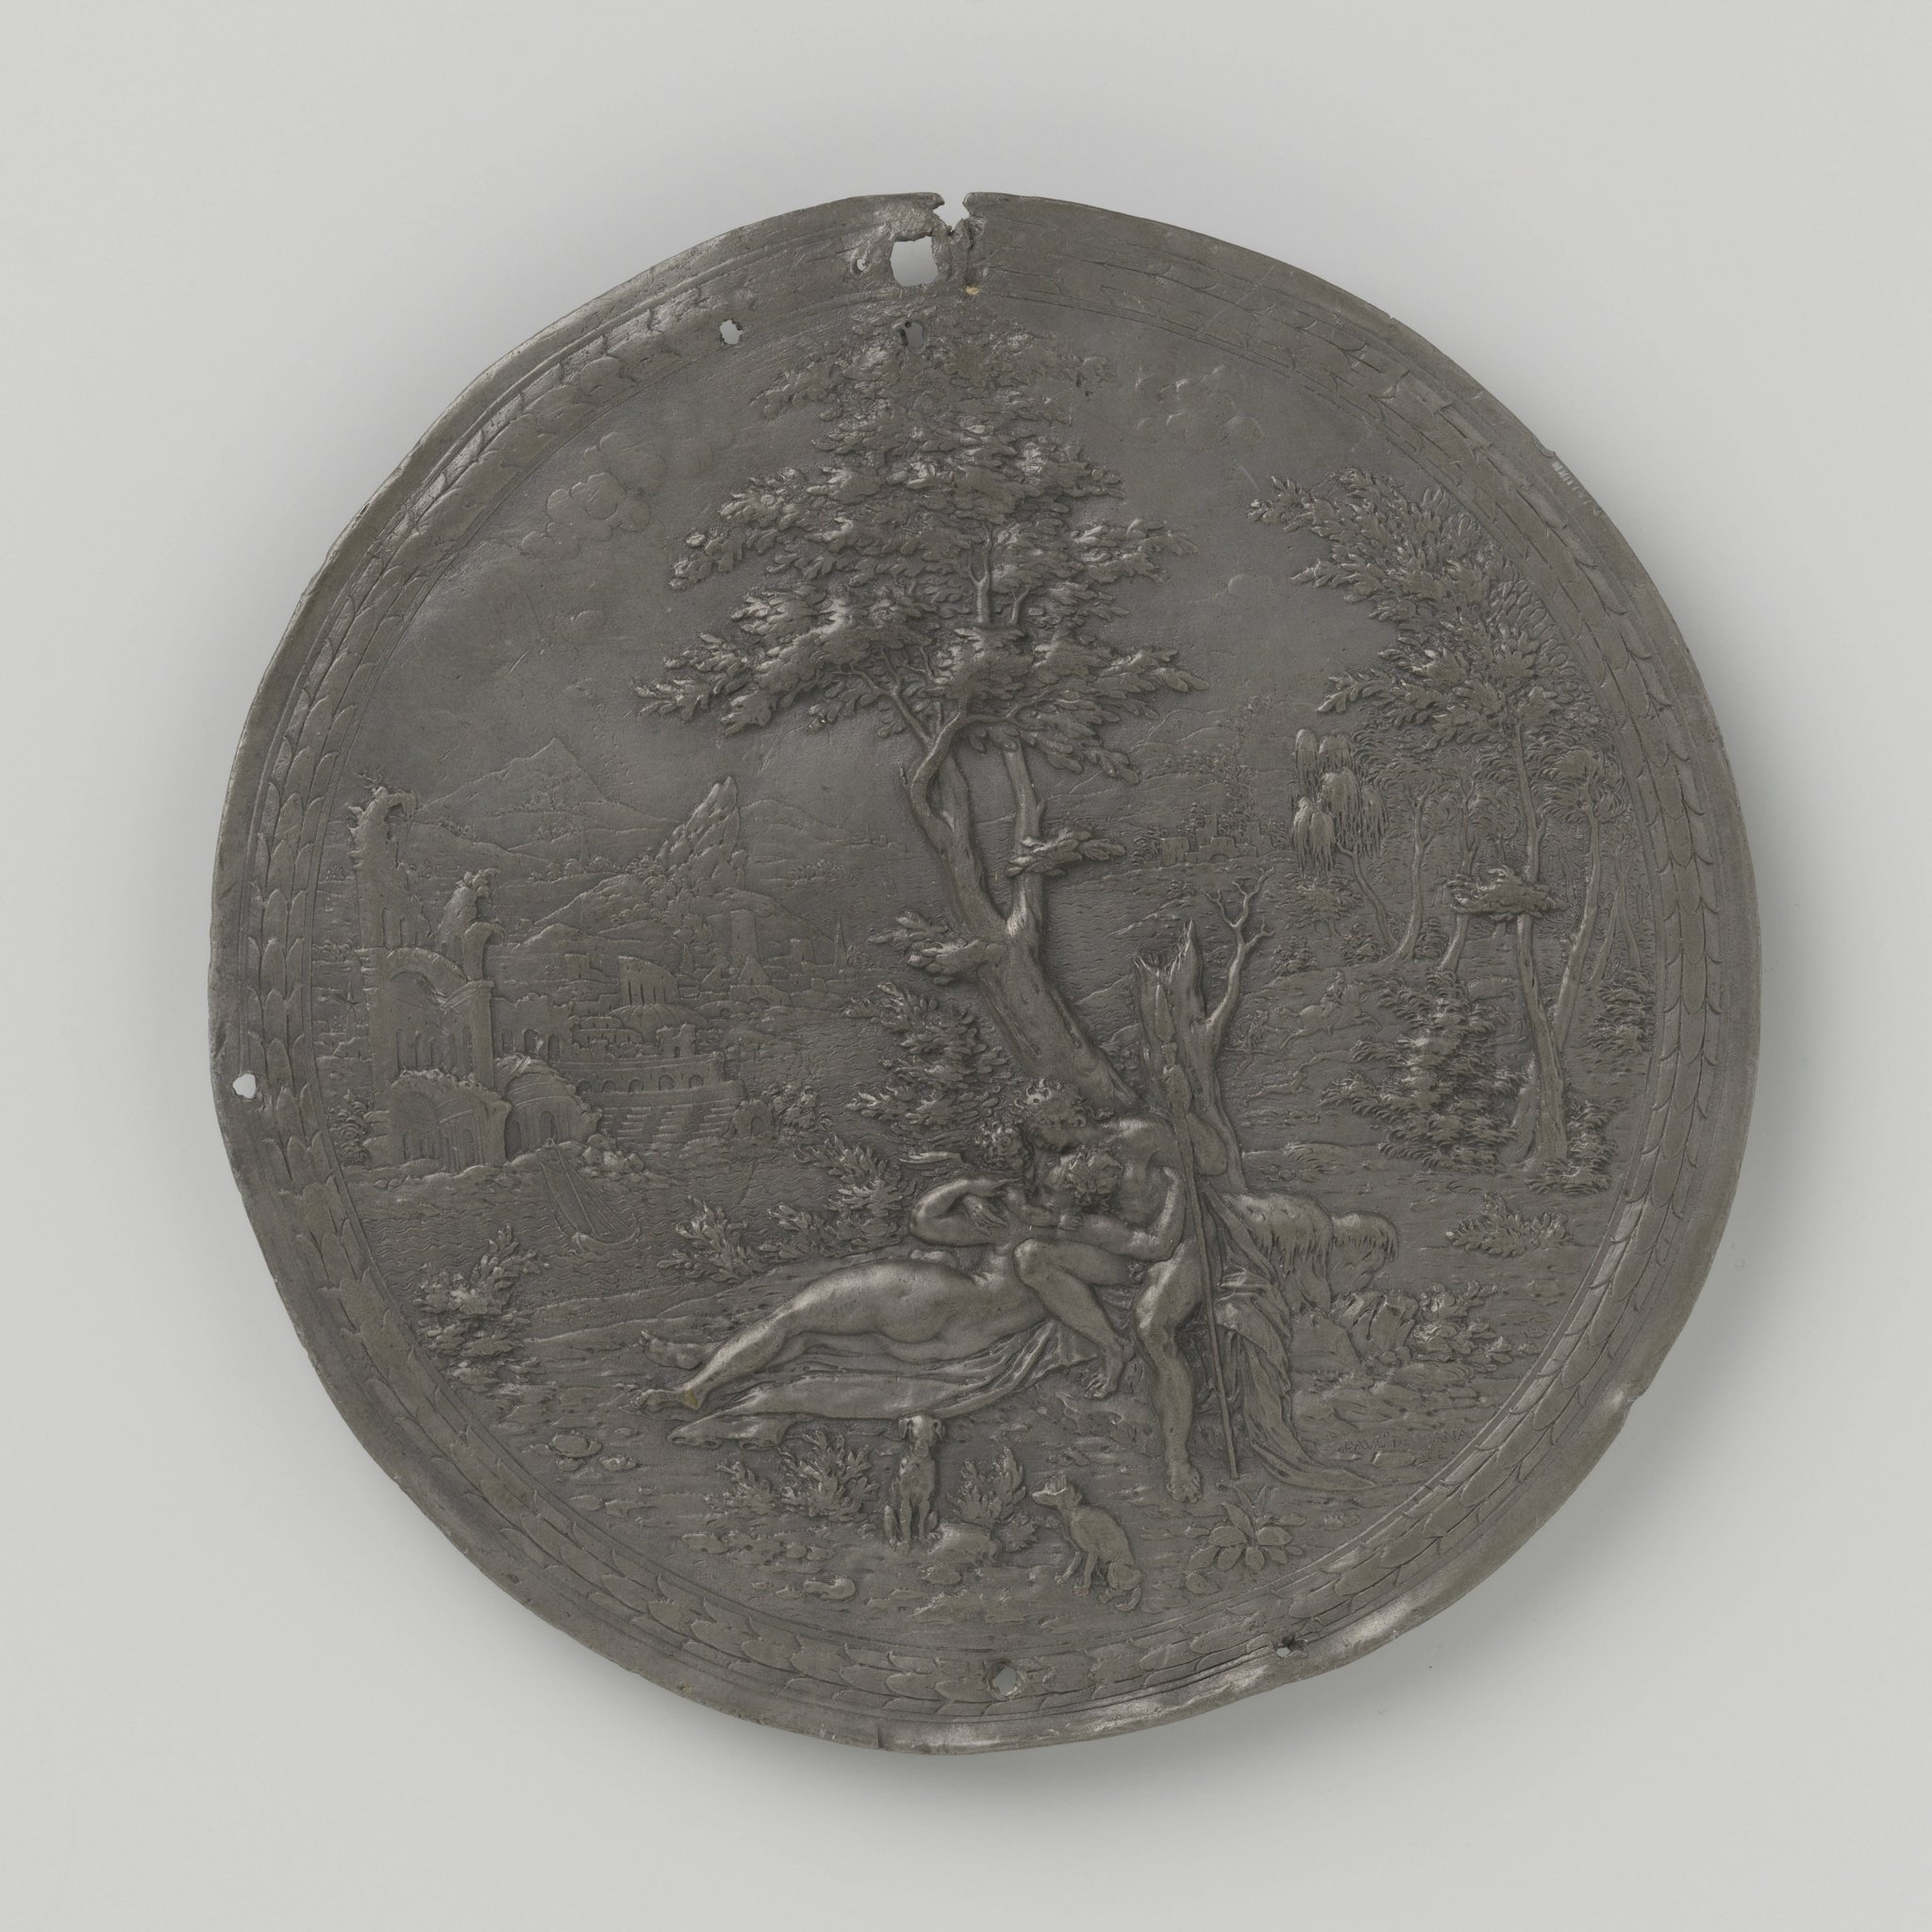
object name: plaque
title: Venus and Adonis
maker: paulus willemsz. van vianen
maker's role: draughtsman, jeweler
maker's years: 1570-1614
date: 1600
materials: lead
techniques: casting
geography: munich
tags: venus and adonis as lovers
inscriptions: signature: ‘PAUL DE VIANA FE’